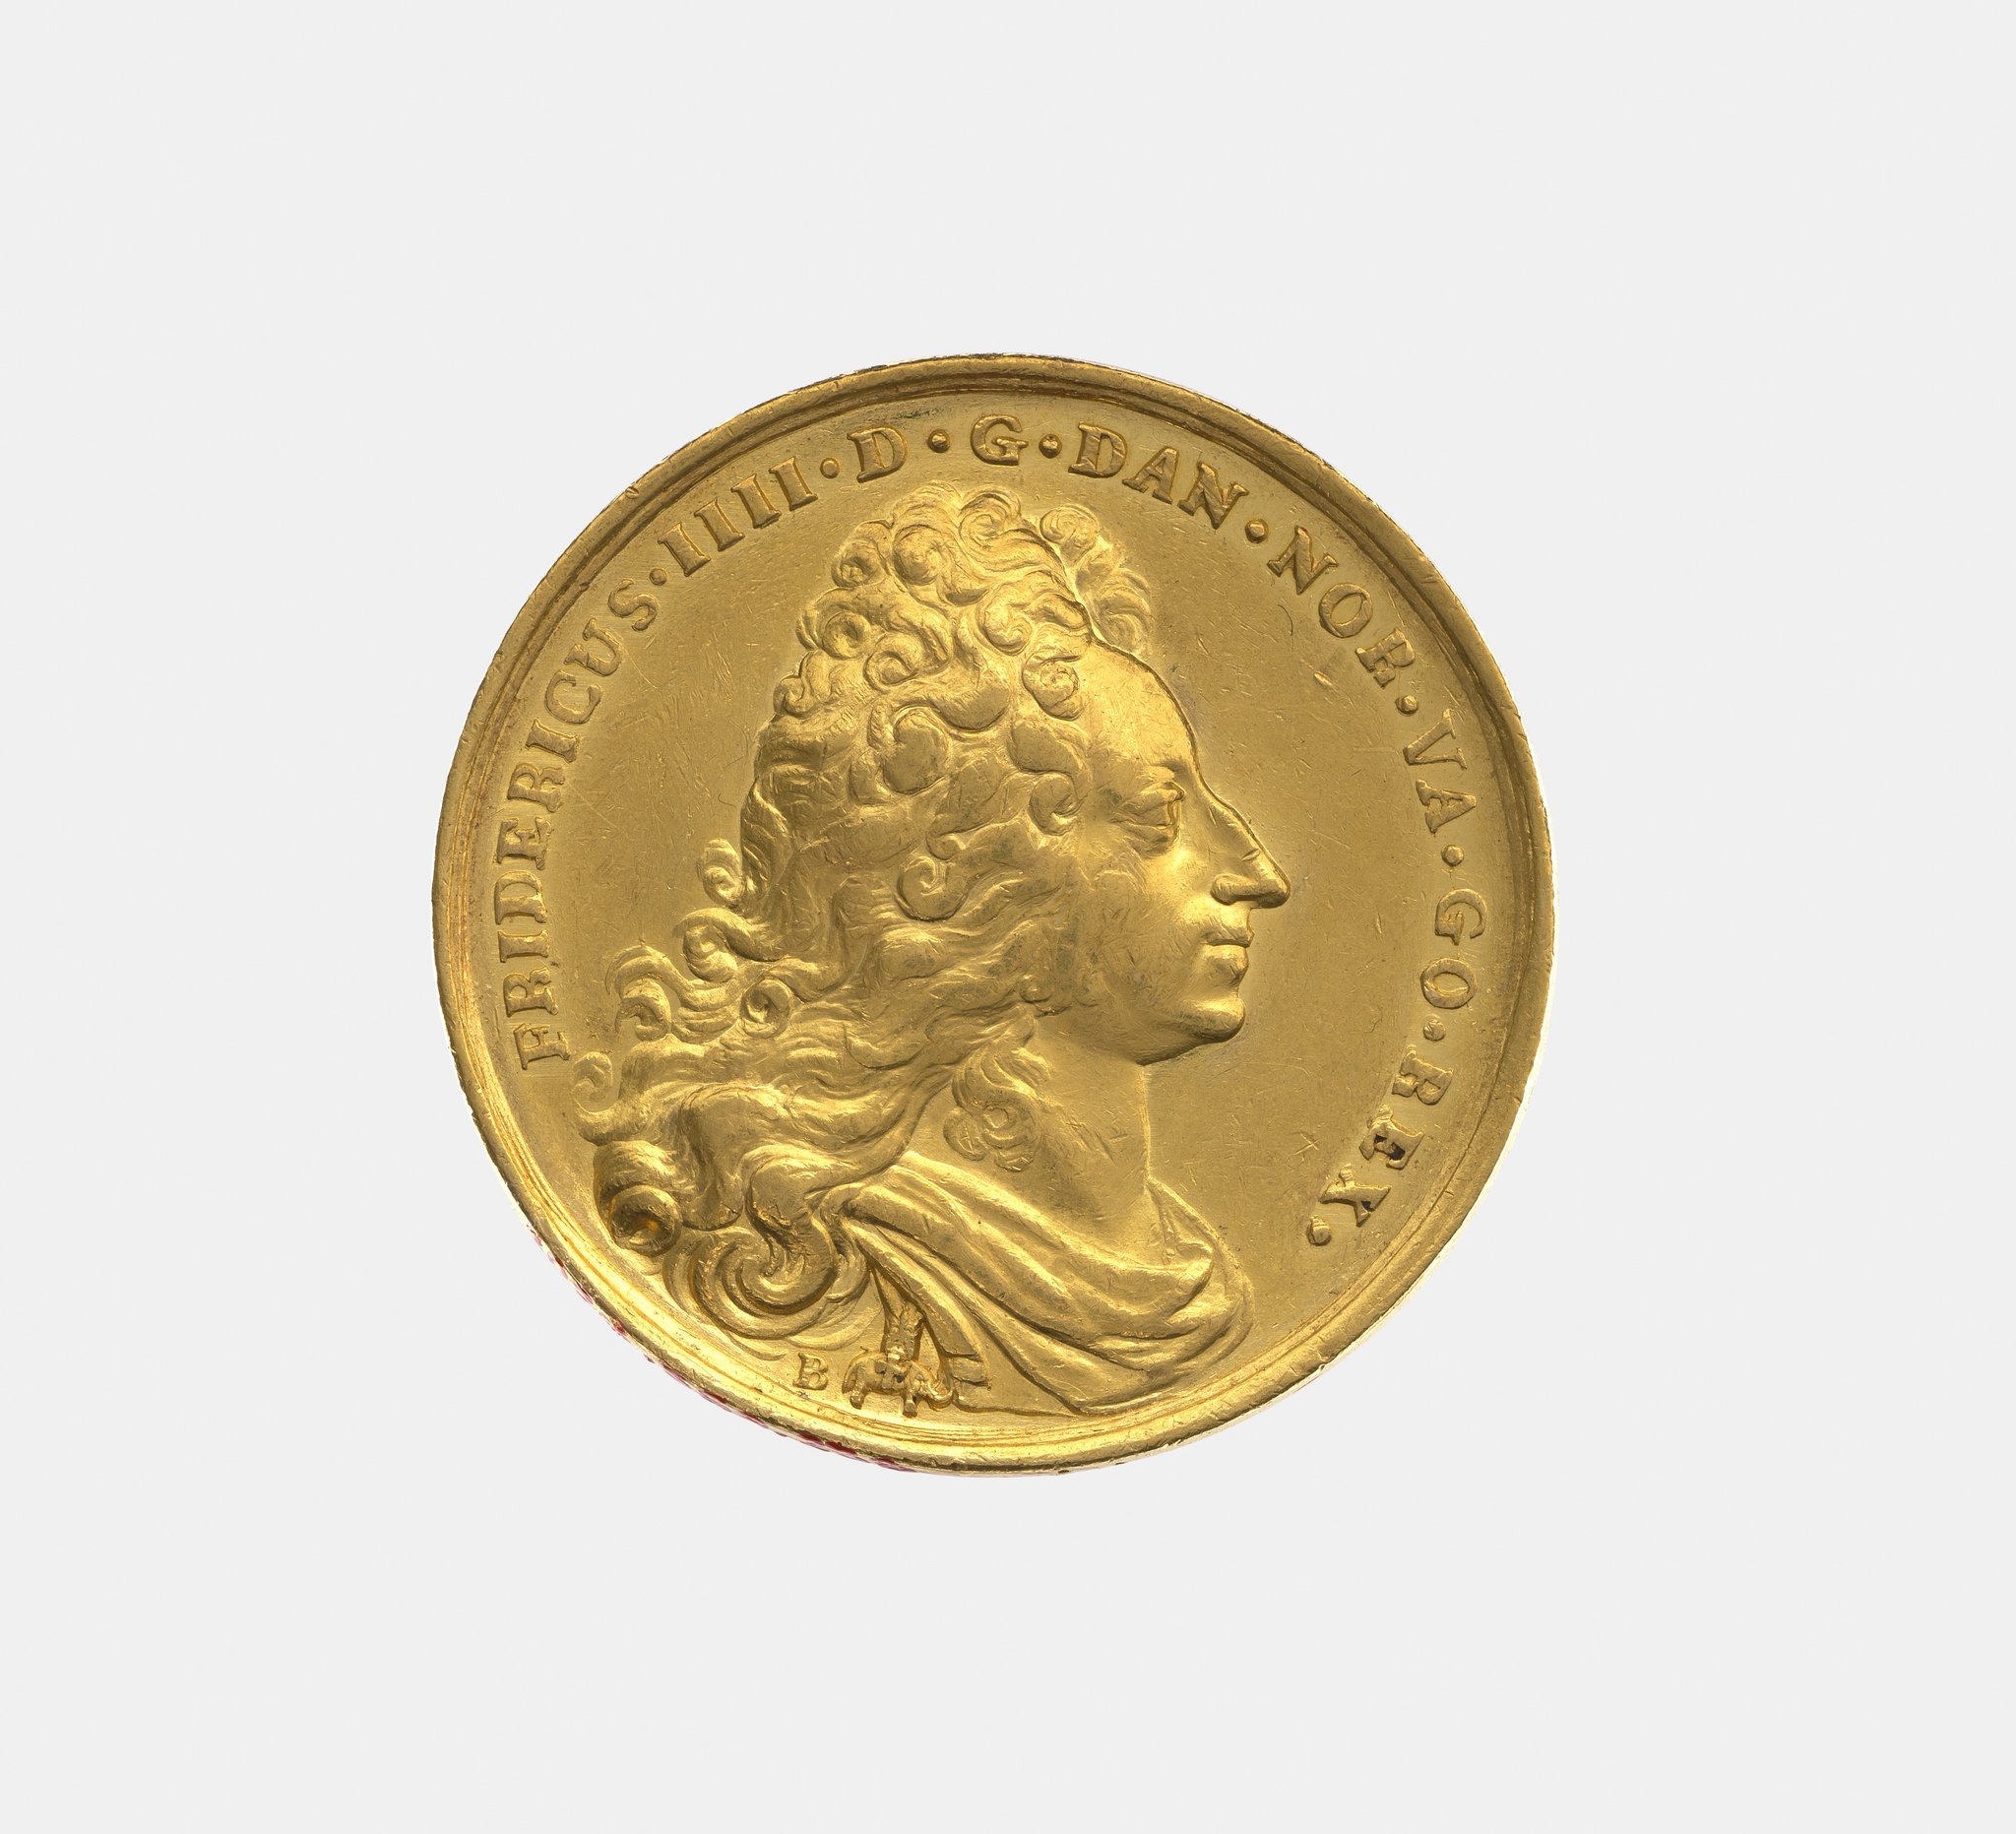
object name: medal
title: Frederick IV / 2nd Centenary of Augsburg Confession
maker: peter berg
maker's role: artist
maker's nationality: danish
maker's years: 1699-1730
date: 1717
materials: gold